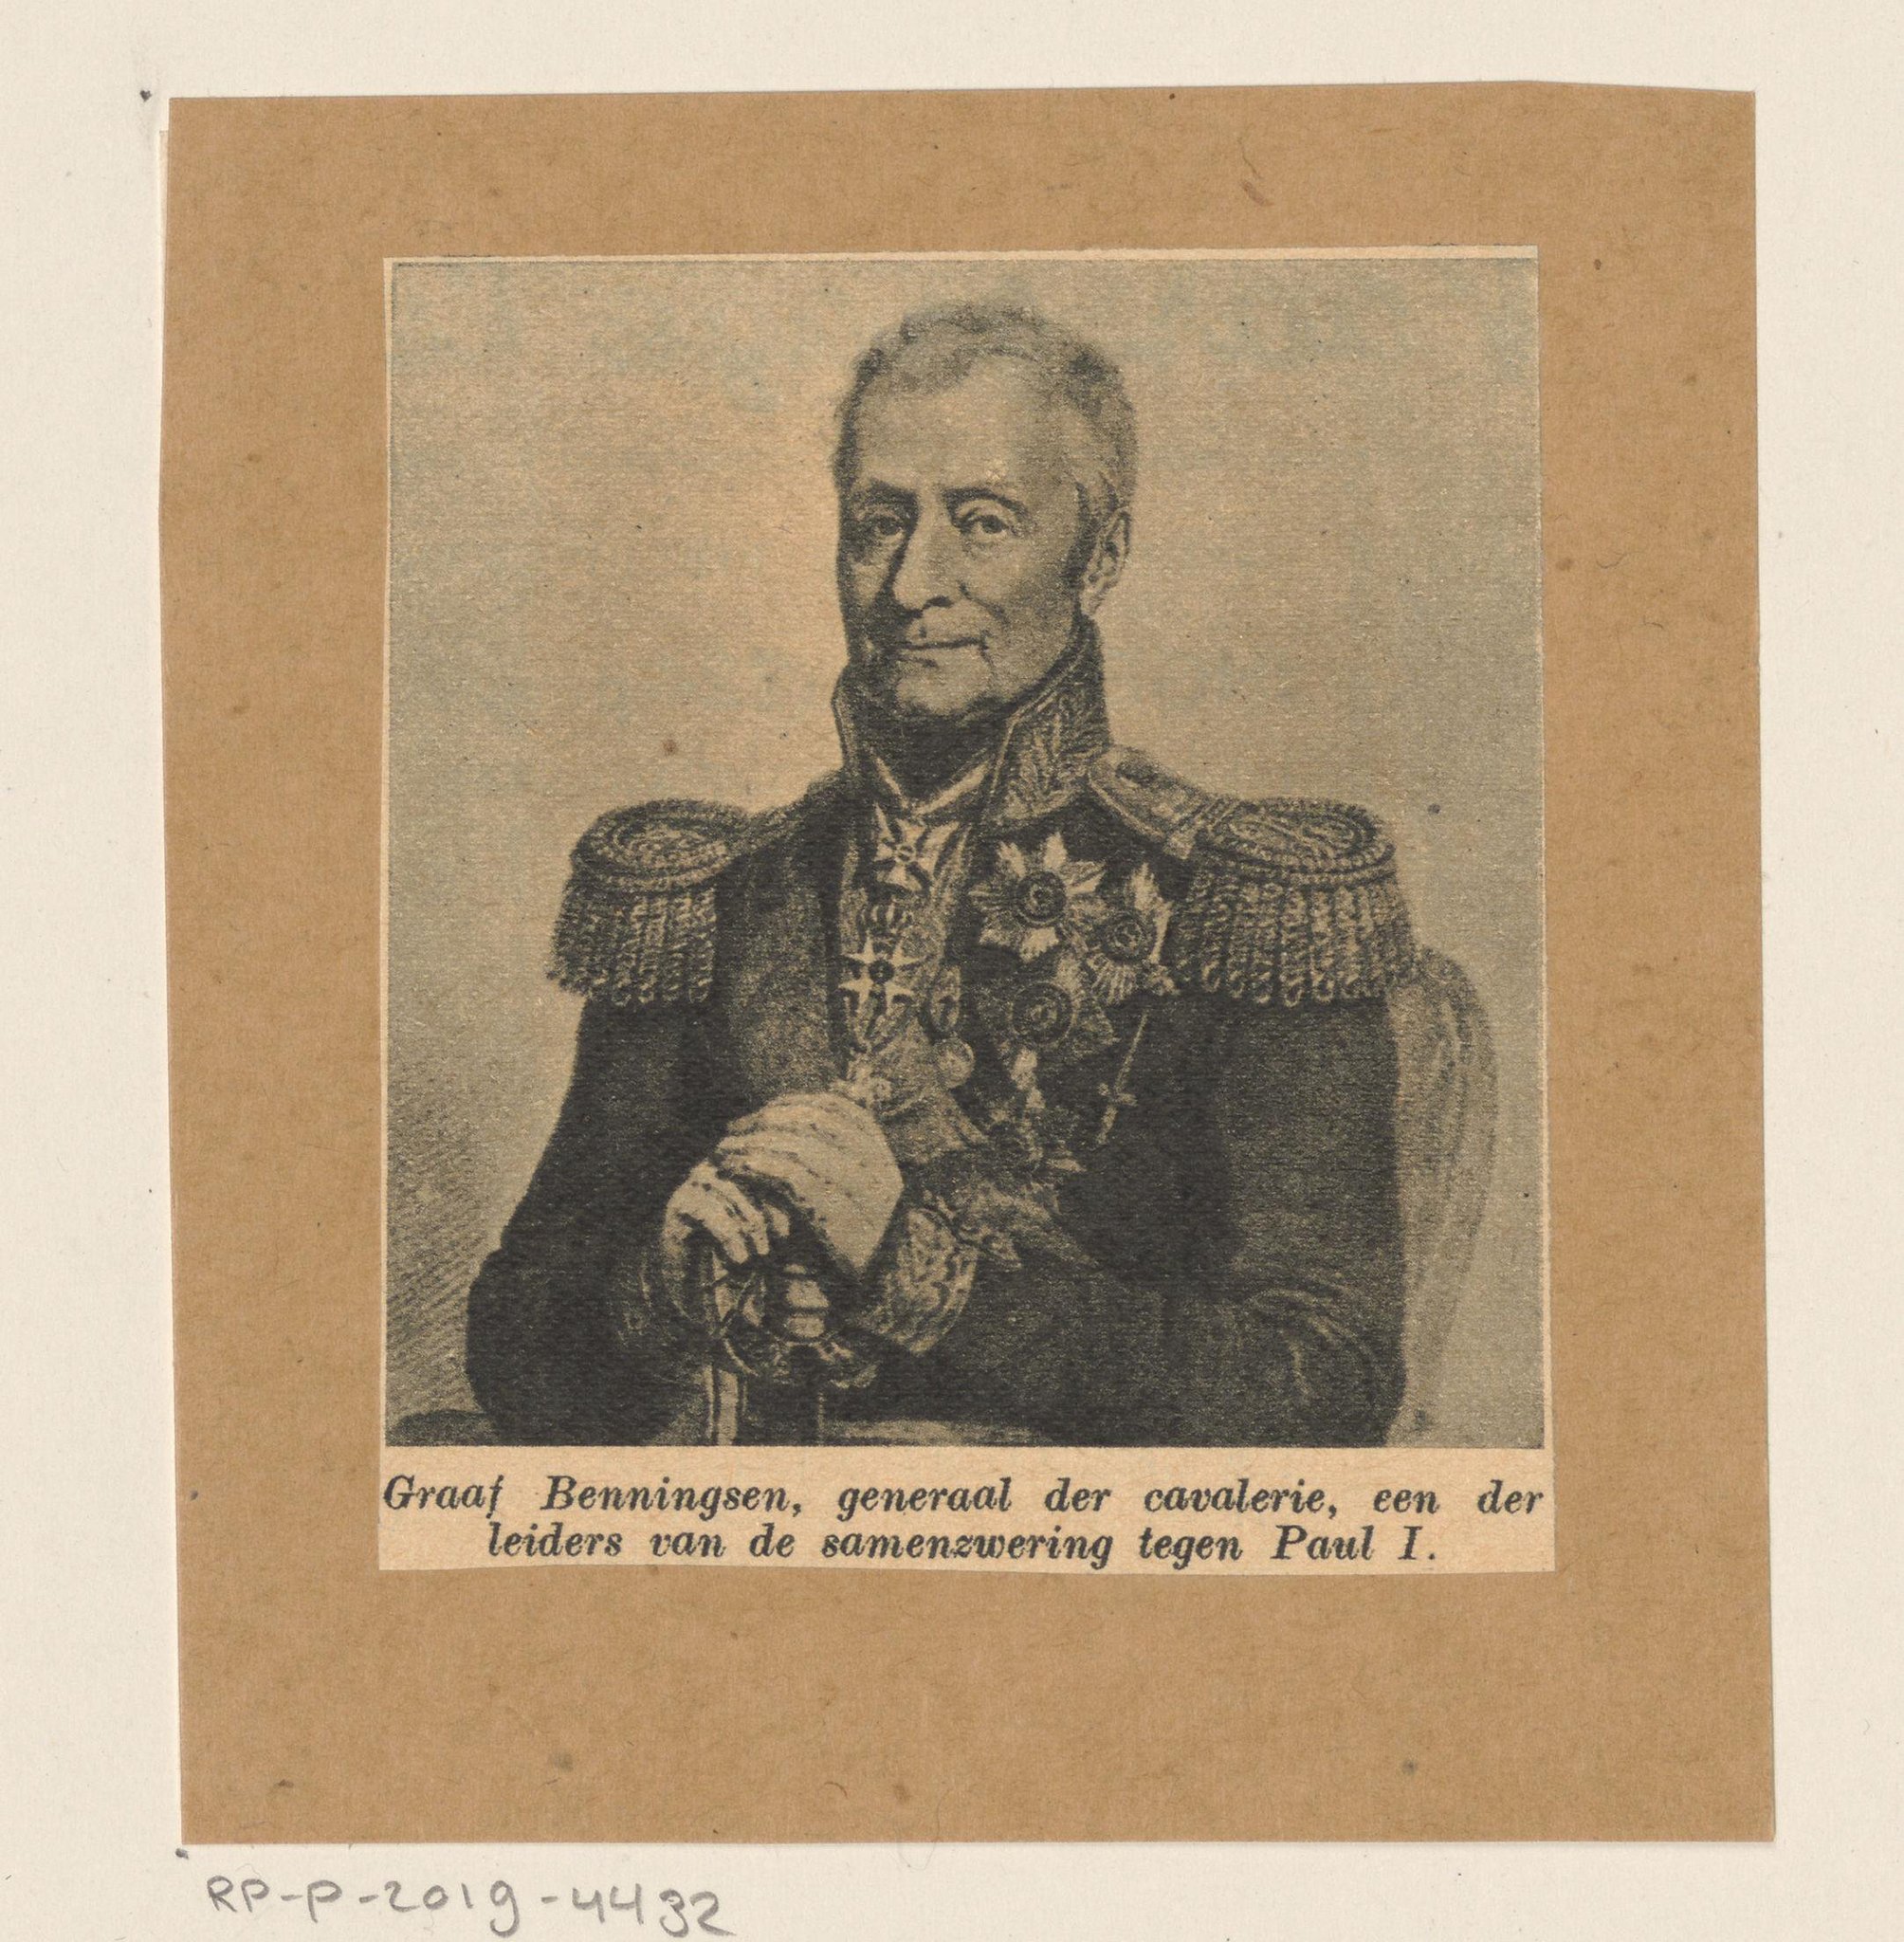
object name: photomechanical print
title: Portret van Levin August von Bennigsen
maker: Anonymous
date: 1875-1925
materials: paper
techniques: rotogravure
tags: historical persons